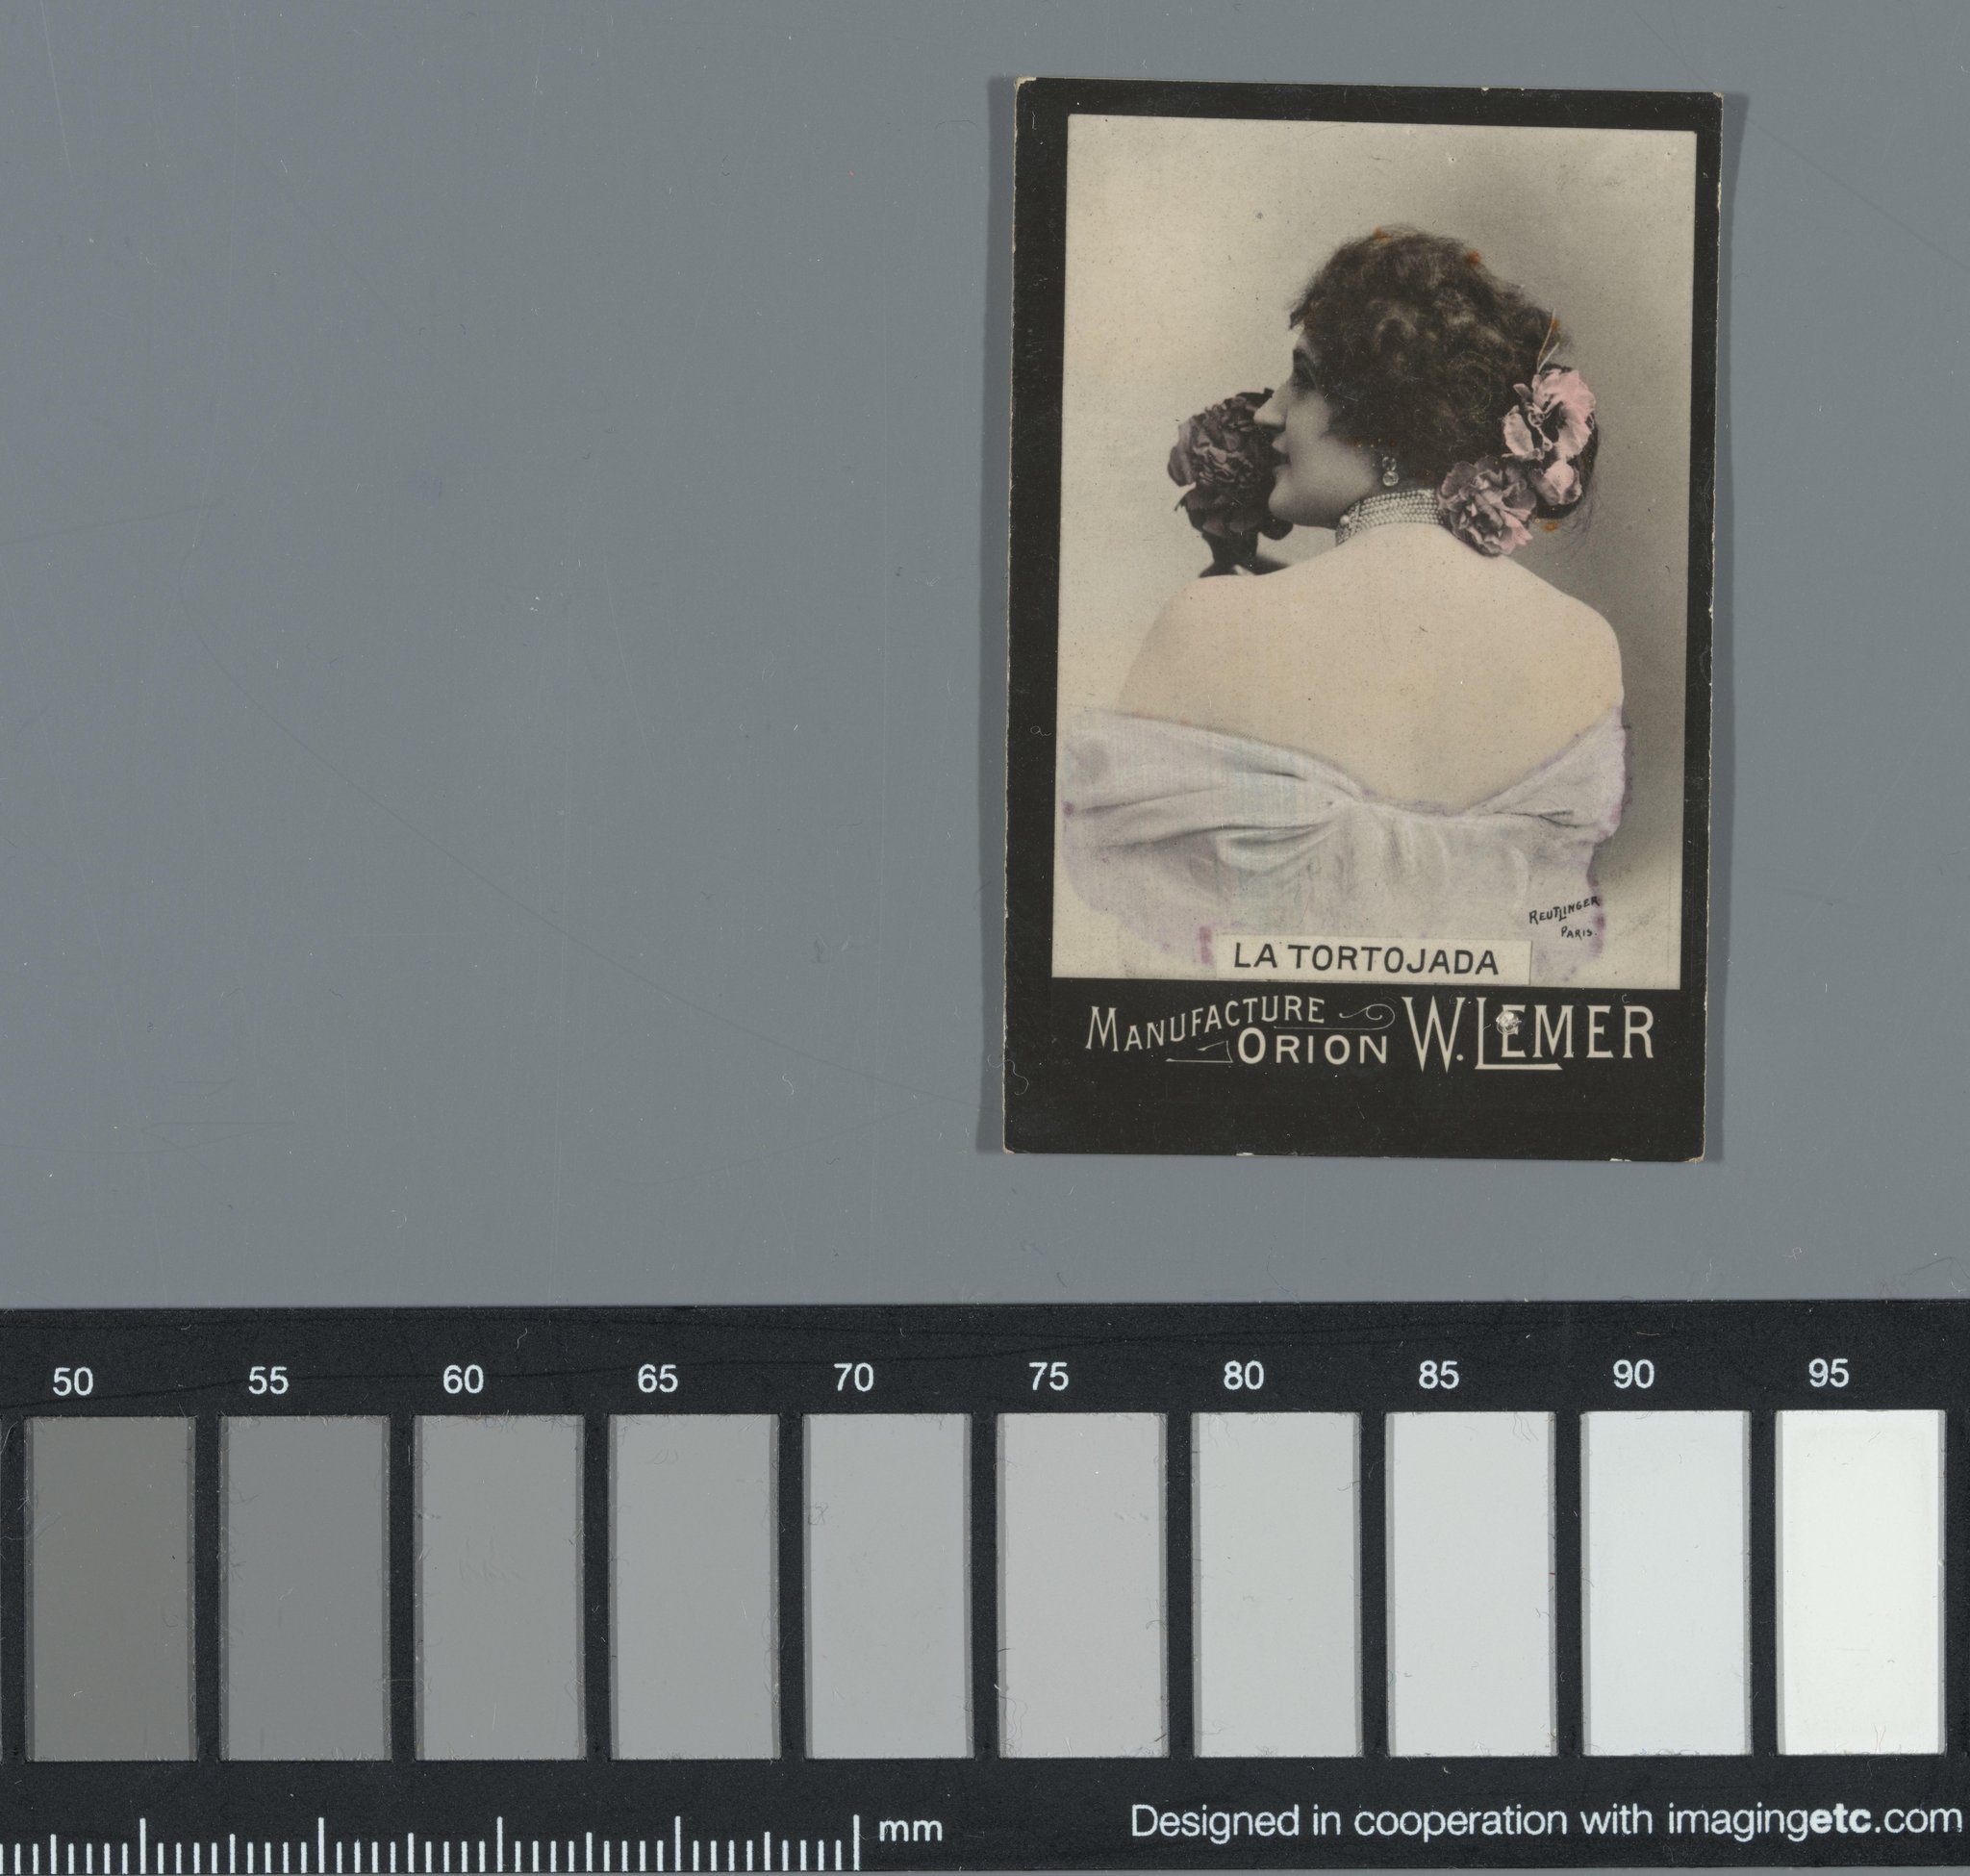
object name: photograph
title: Portret van La Tortajada, reclame voor Orion W. Lemer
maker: charles reutlinger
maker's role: publisher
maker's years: 1816-1880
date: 1895-1910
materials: paper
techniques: gelatin silver print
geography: france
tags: adult woman, historical persons, france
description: Dergelijke foto's stonden bekend als 'zwartjes'. Men verkreeg ze bij aanschaf van bepaalde merken thee, cacao, sigaretten, beschuit, etc. om te verzamelen. Er waren speciaal voor de 'zwartjes' verzamelalbums in omloop.